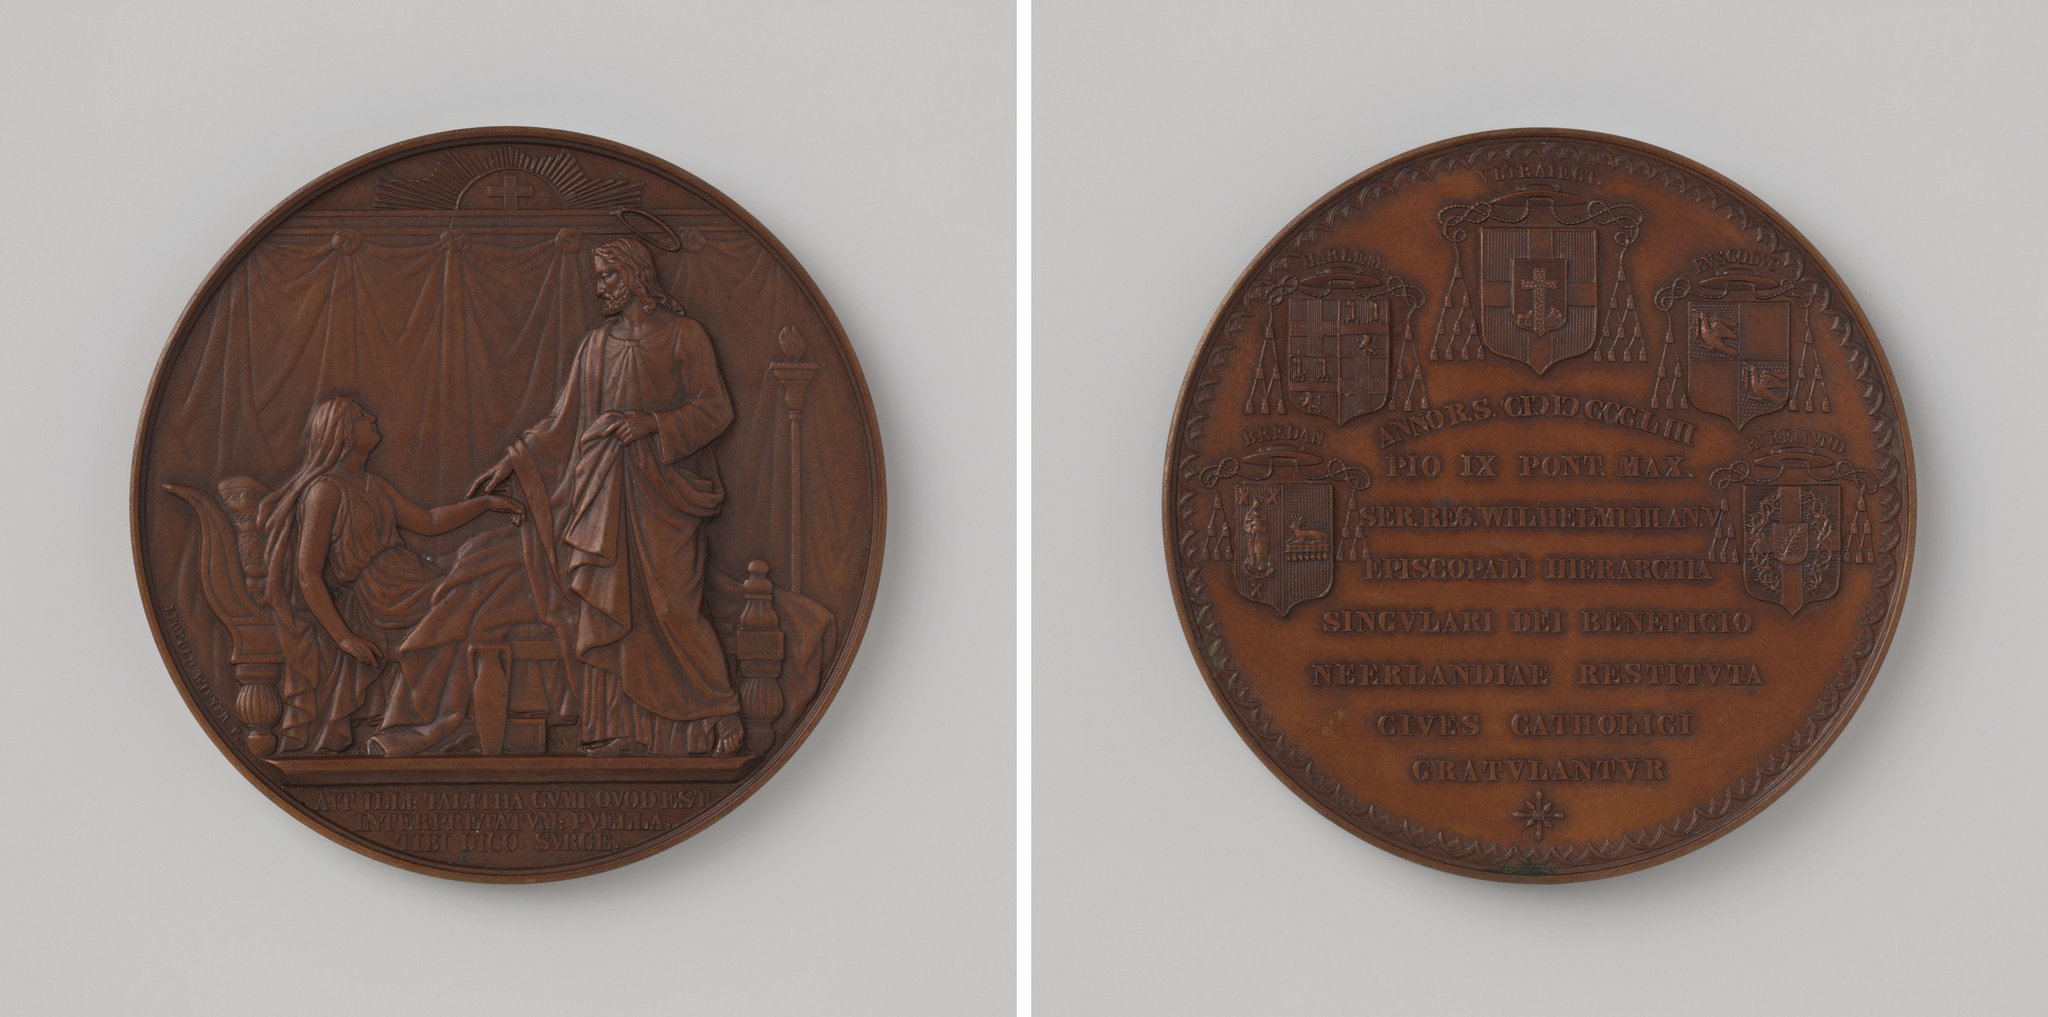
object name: history medal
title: Herinvoering van de Bisschoppelijke Hiërarchie in Nederland 1853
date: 1853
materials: bronze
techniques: striking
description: Bronzen penning, op de voorzijde Christus die de dochter van Jairus tot leven wekt in een antiek ogende ziekenzaal, in de afsnede drie regels tekst, op de keerzijde acht regels tekst onder de wapenschilden van het aartsbisdom Utrecht en de vier Nederlandse bisdommen.